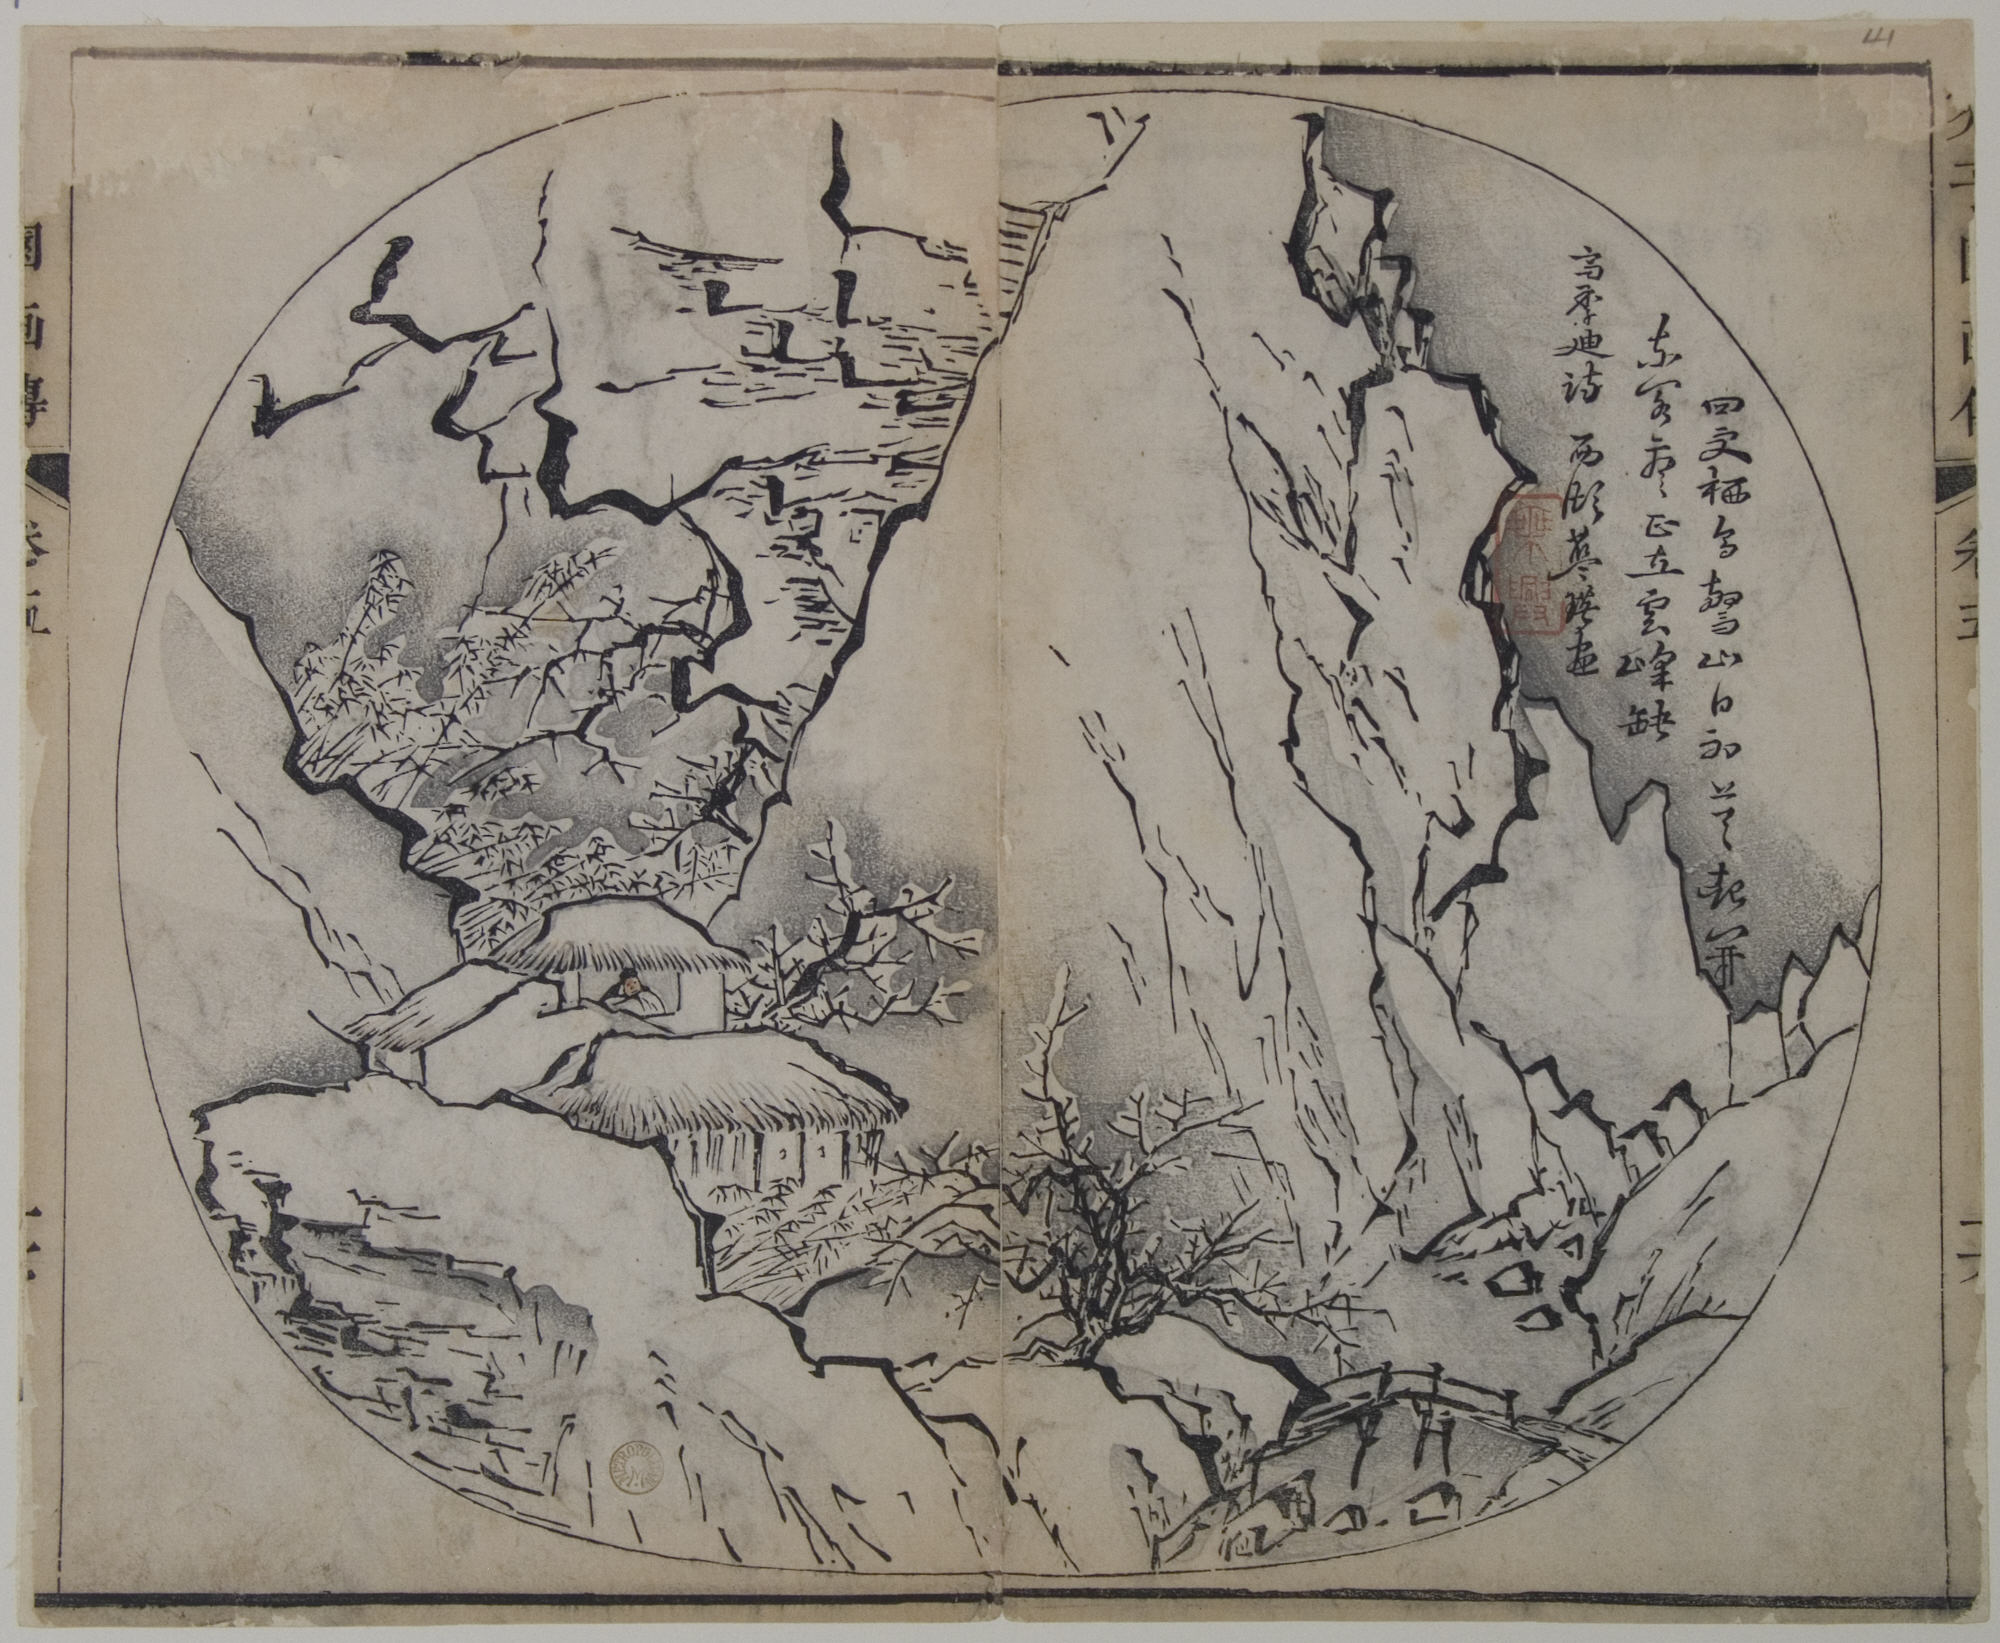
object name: print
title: Page from the Mustard Seed Garden Manual of Painting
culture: chinese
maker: wang gai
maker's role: artist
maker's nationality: chinese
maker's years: 1645-1710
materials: ink, paper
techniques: woodblock print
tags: mountains,trees